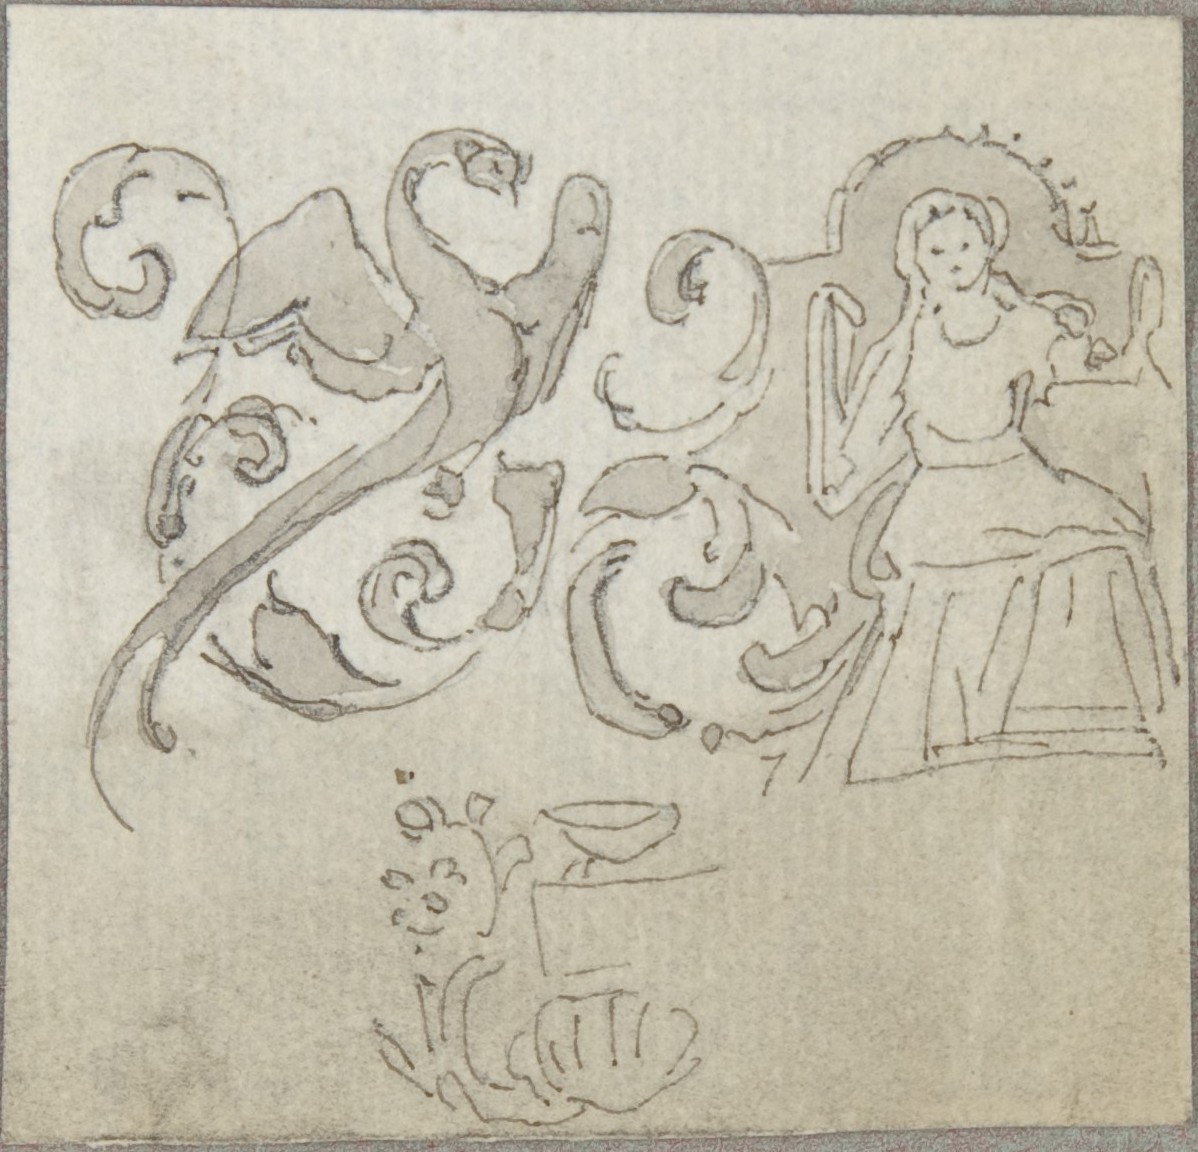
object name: drawing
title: Sketch of Seated Female Figure with Foliate Decoration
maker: william pitts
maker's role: artist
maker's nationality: british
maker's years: 1790-1840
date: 1805-1840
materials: ink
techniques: brush, pen, wash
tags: women